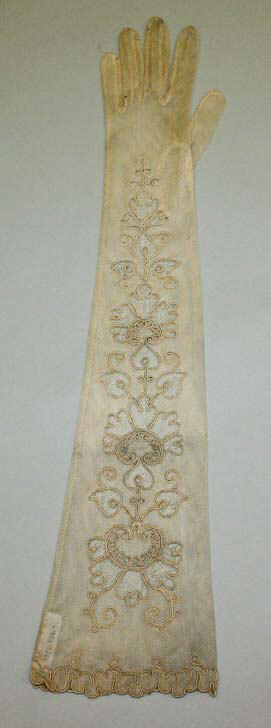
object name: glove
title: Gloves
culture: american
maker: kayser-roth glove co., inc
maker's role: designer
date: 1900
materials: silk